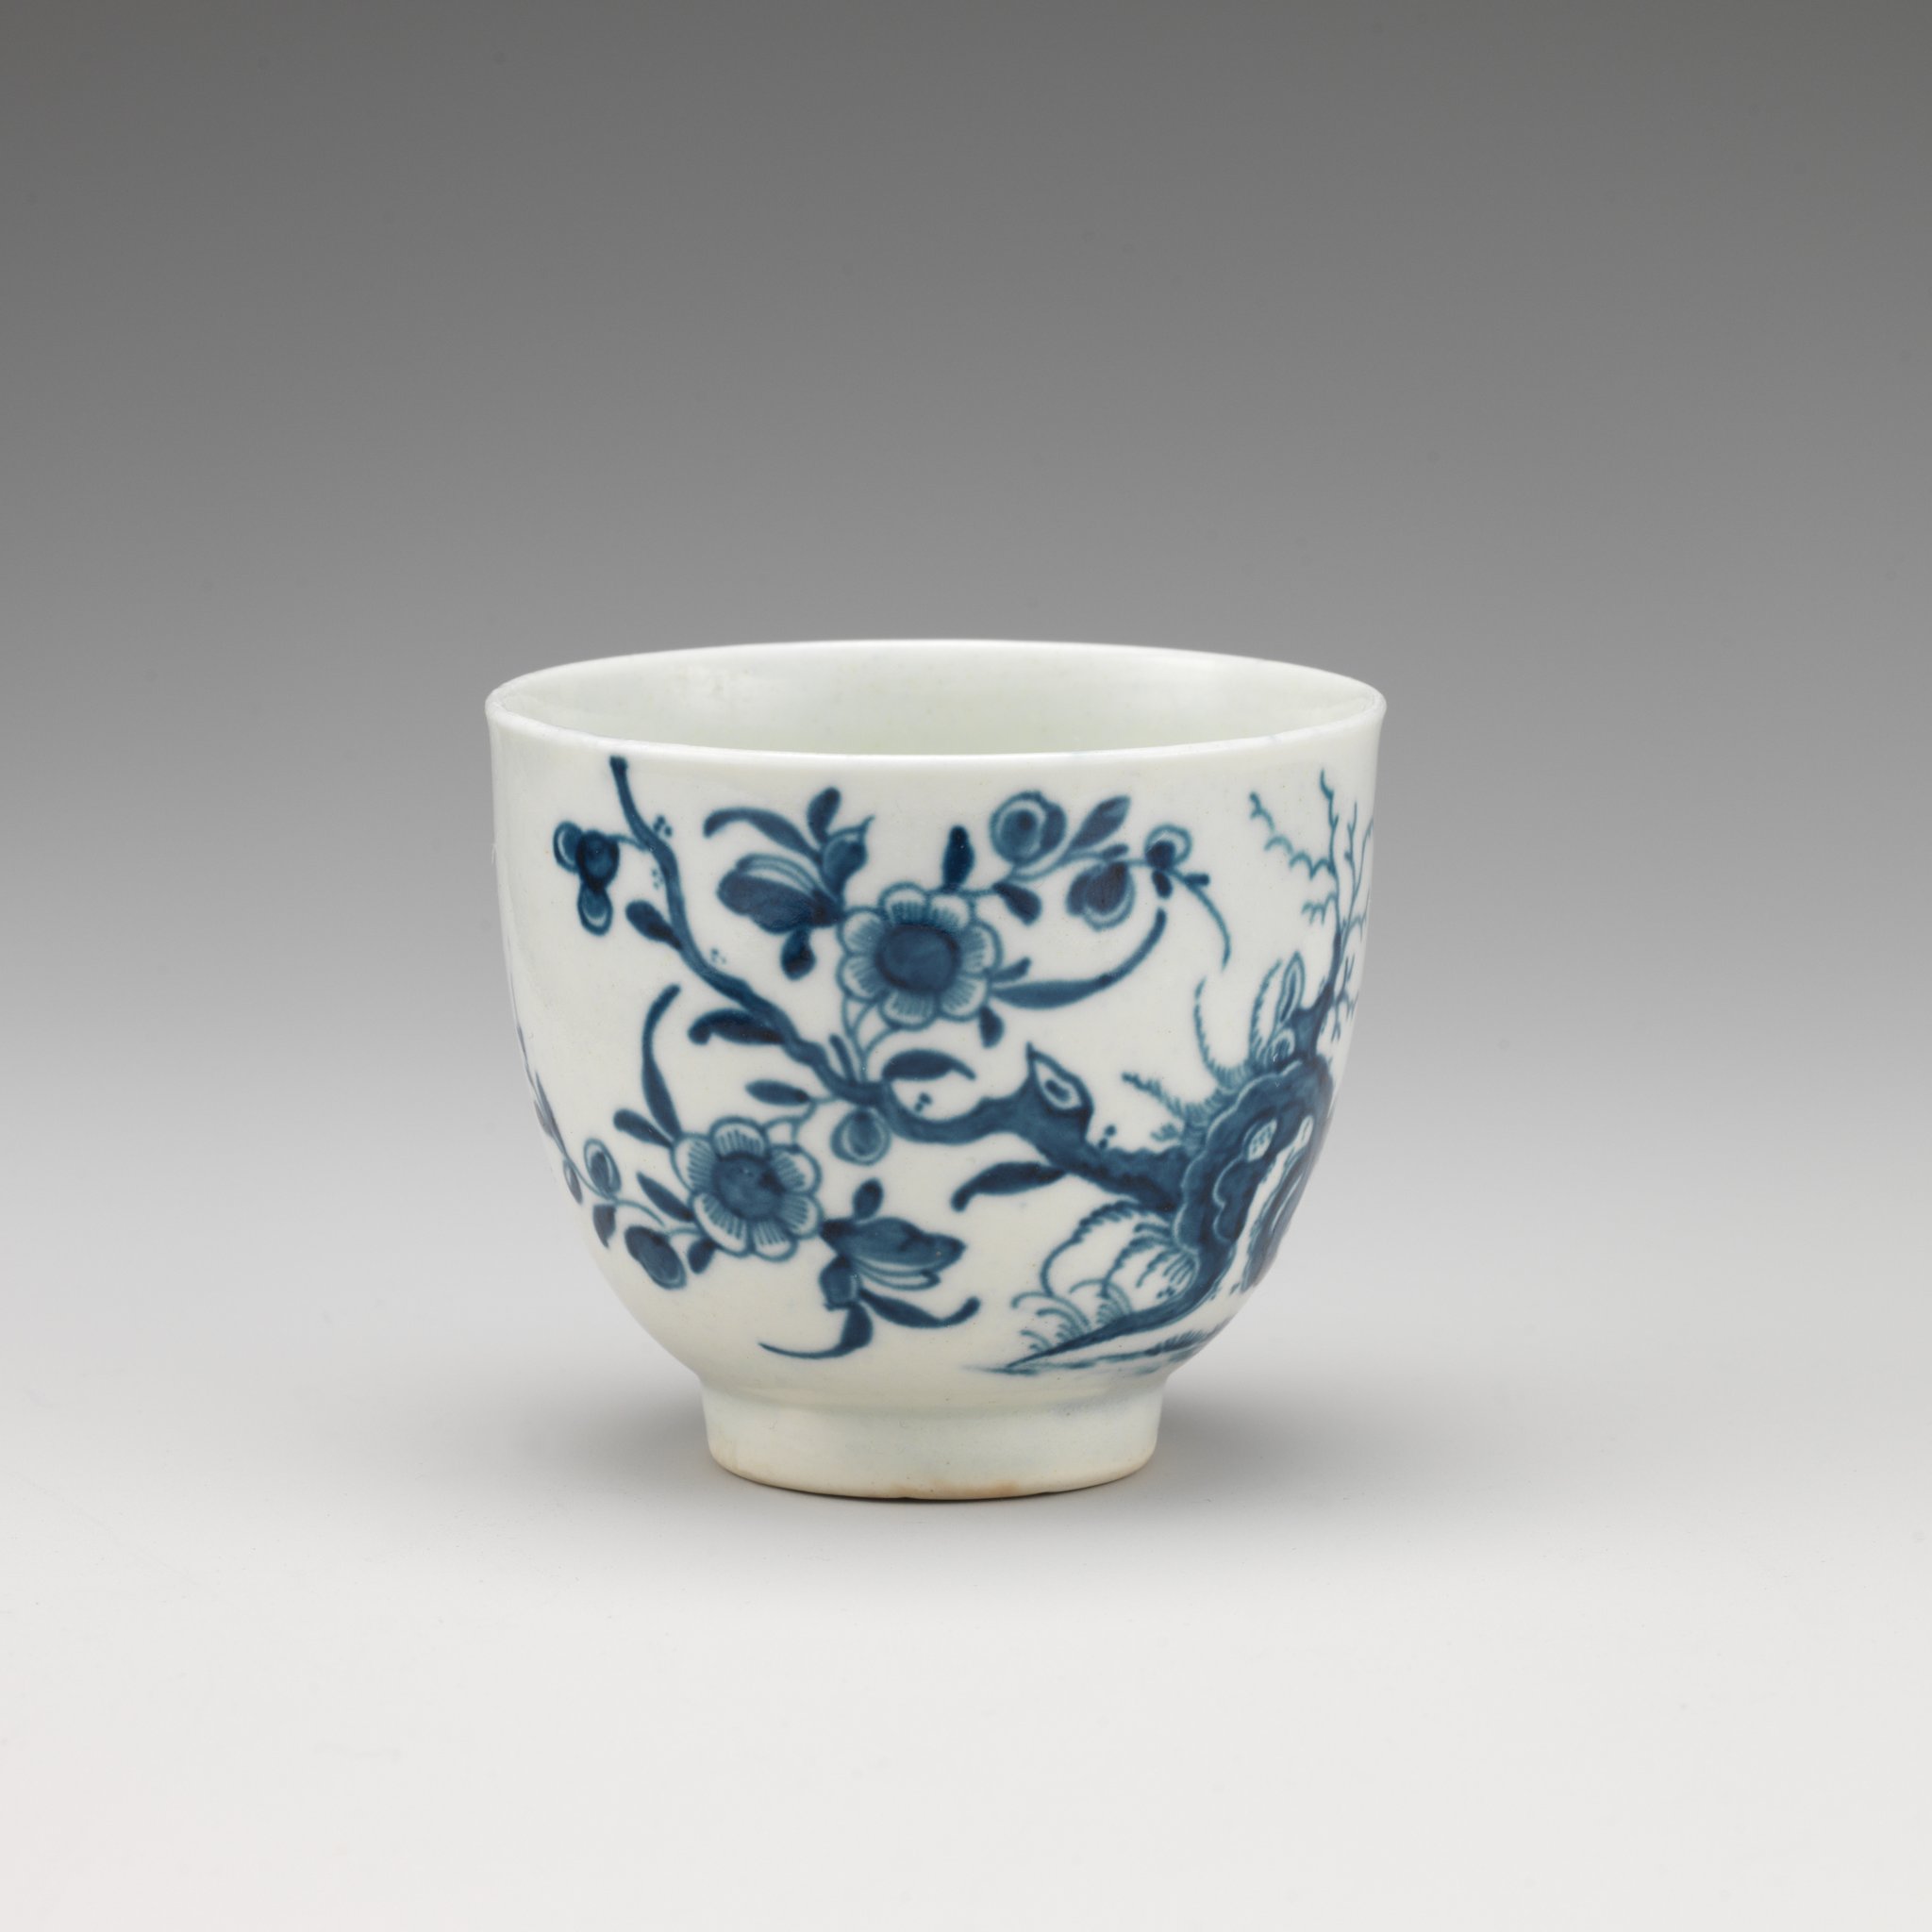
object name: bowl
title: Miniature bowl (part of a service)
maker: worcester factory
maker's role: factory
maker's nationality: british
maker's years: 1751-2008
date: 1760-1762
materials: soft paste porcelain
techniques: underglaze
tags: flowers